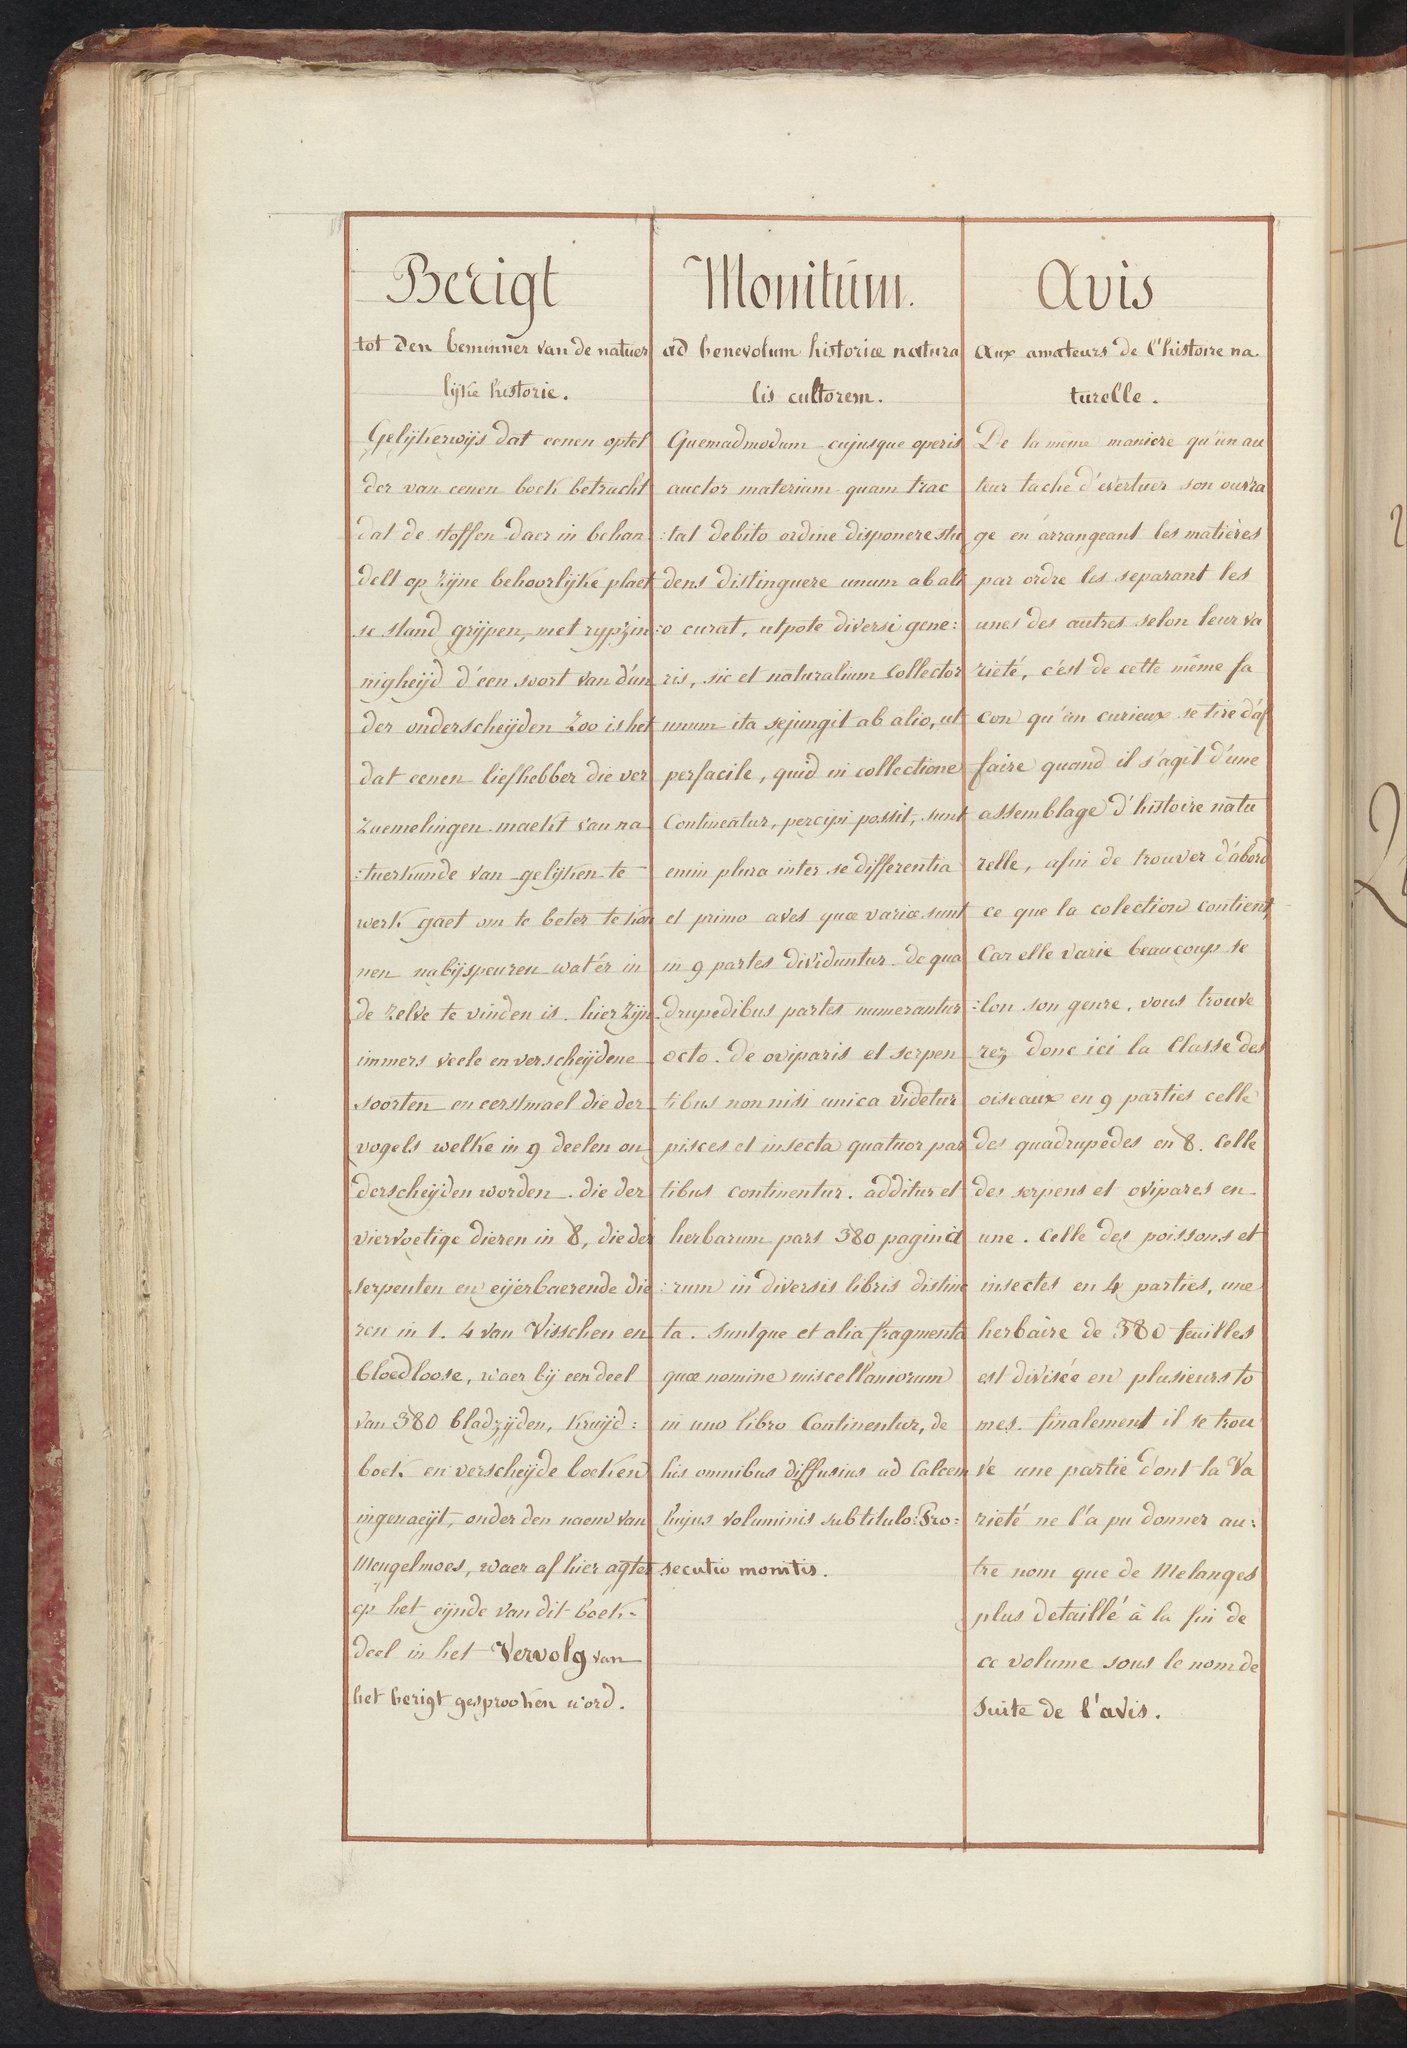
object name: manuscript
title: Bericht aan de liefhebber van de natuurlijke historie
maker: joseph van huerne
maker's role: kunstliefhebber, mecenas, verzamelaar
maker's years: 1752-1844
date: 1800-1825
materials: ink, paper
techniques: handwriting, pen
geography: bruges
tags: handwriting, written text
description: Inleidende teksten in drie kolommen in het Nederlands, Latijn en Frans, waarin de samensteller van de albums zich tot de lezer richt. Onderdeel van het eerste album met tekeningen van viervoeters. Eerste van twaalf albums met tekeningen van dieren, vogels en planten bekend rond 1600, gemaakt in opdracht van keizer Rudolf II. Met toelichting in Nederlands, Latijn en Frans.